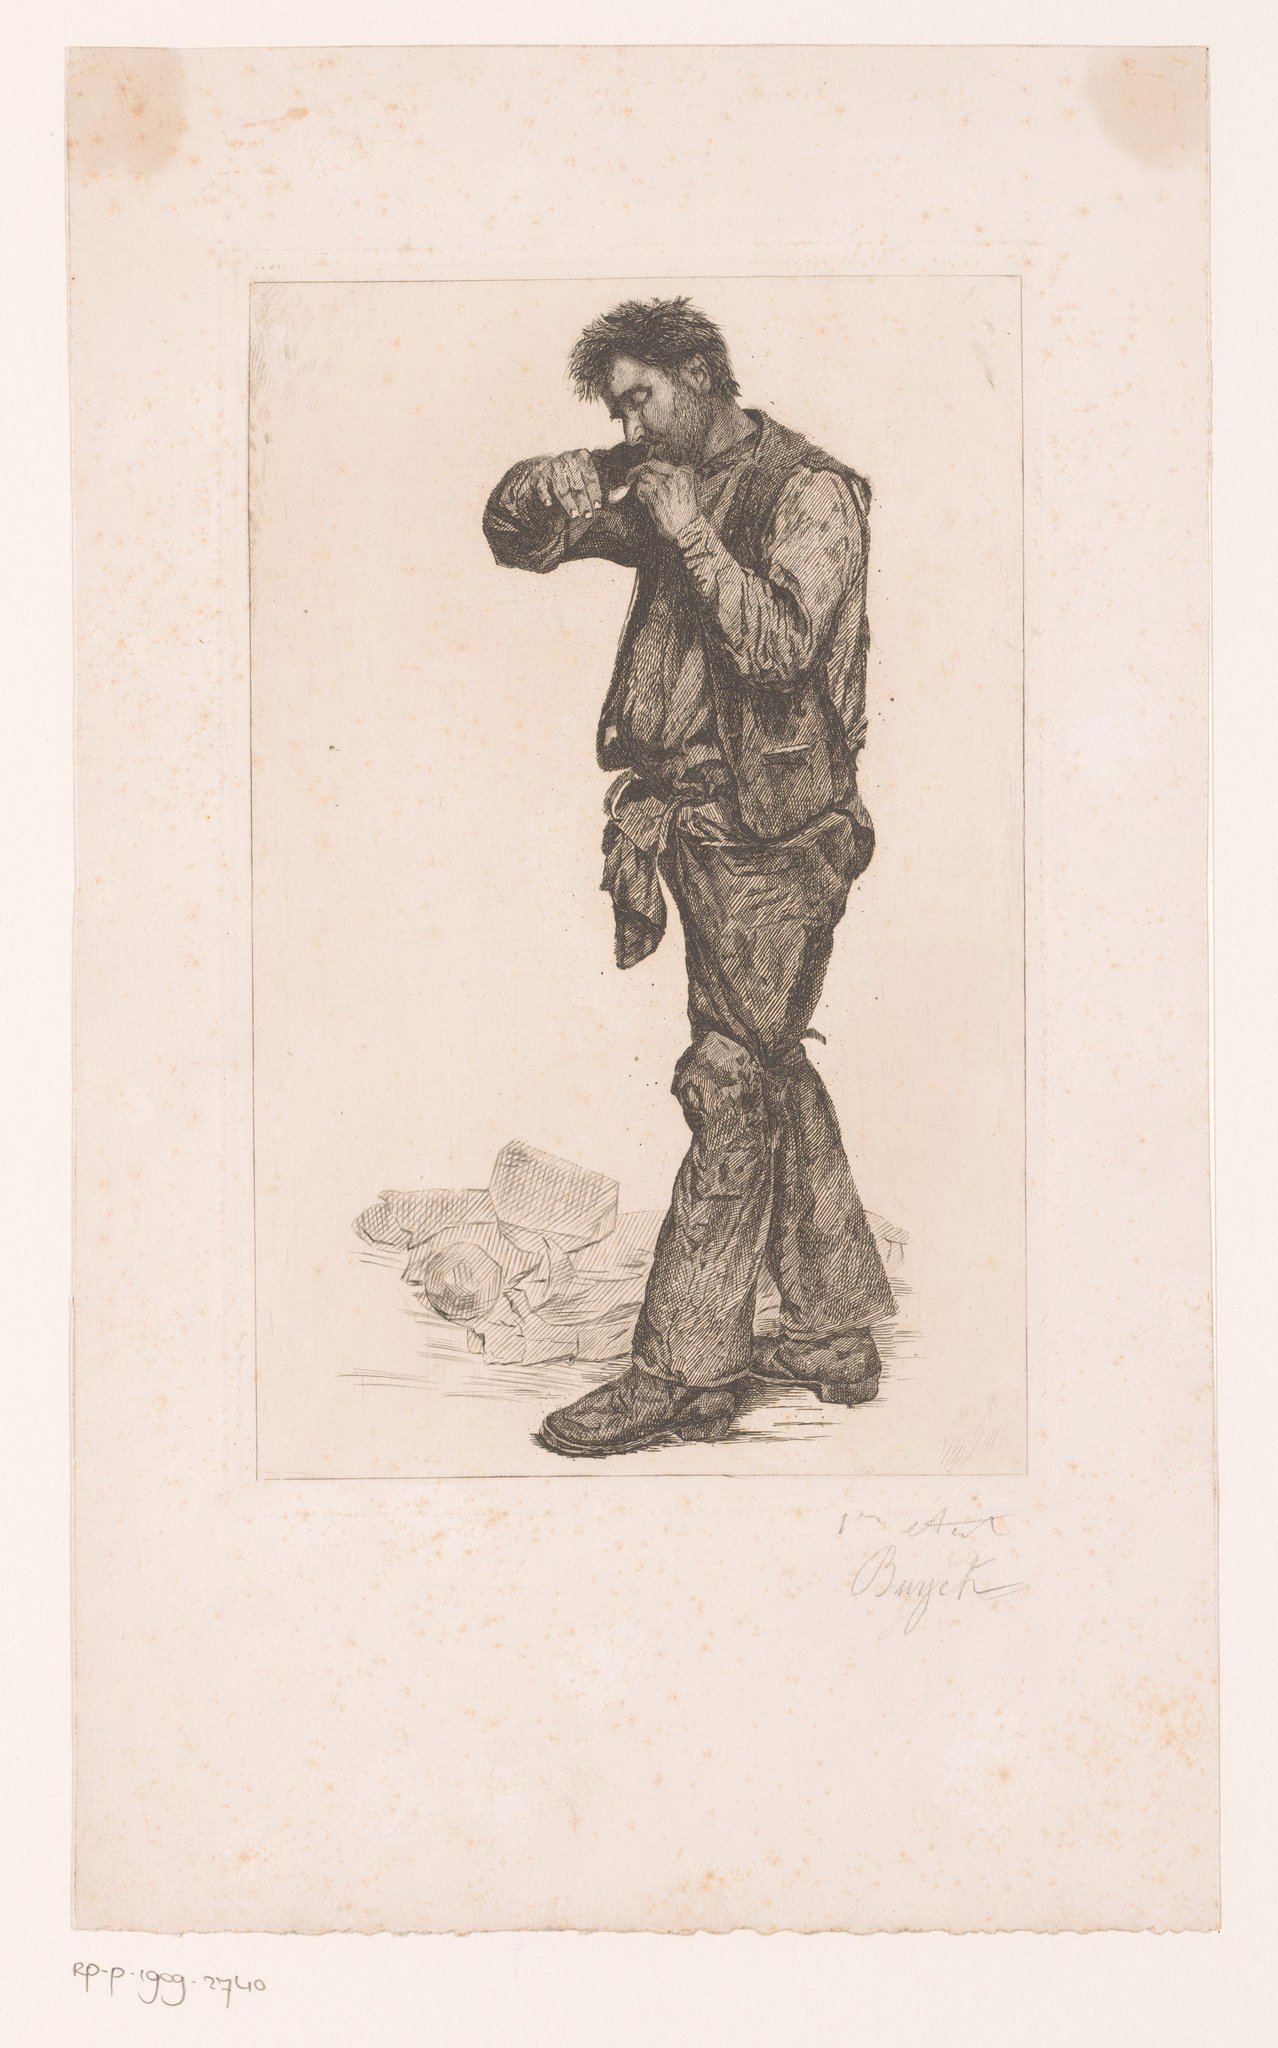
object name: print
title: Schoorsteenveger steekt zijn pijp aan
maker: florimond buyck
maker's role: print maker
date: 1870-1909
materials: paper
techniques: etching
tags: pipe ~ tobacco, handicrafts ~ maintenance and repair (with name of trade or profession)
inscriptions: collector's mark: Lugt 2228, annotation: ‘1er etat’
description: Sterfdatum prentmaker onbekend. Derhalve is voor bepaling van de rechten van dit object de verwervingsdatum aangehouden.